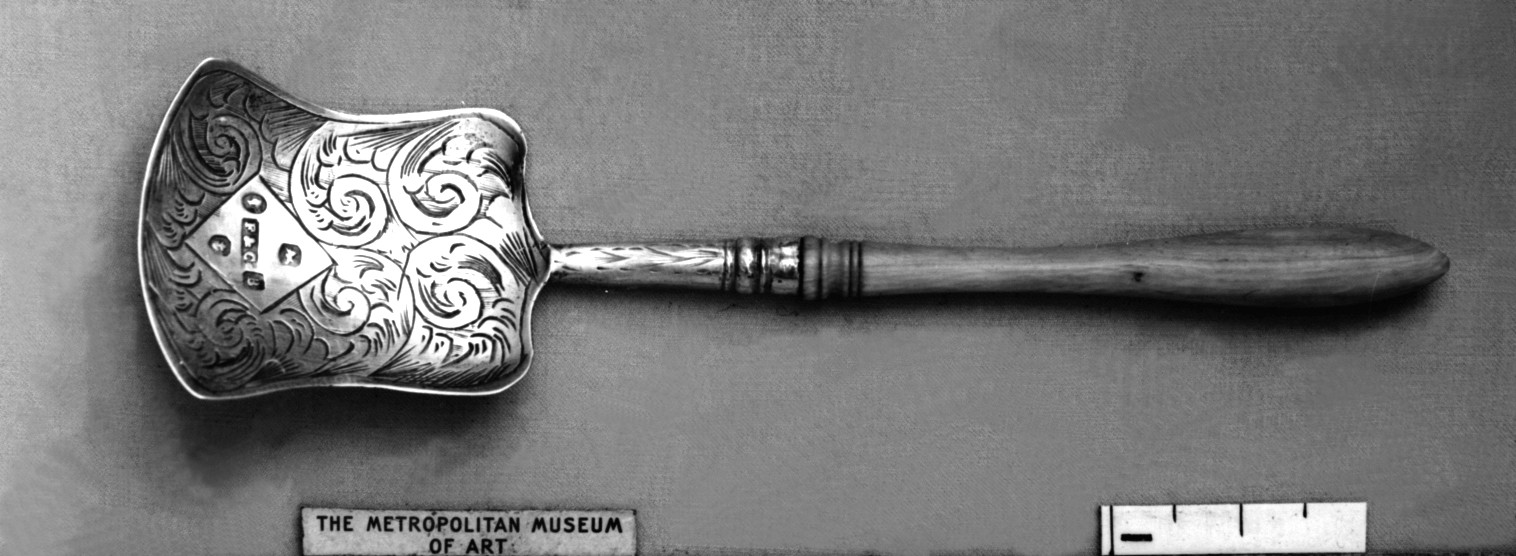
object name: caddy spoon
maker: f. & co.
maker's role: maker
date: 1850-1851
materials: ivory, silver